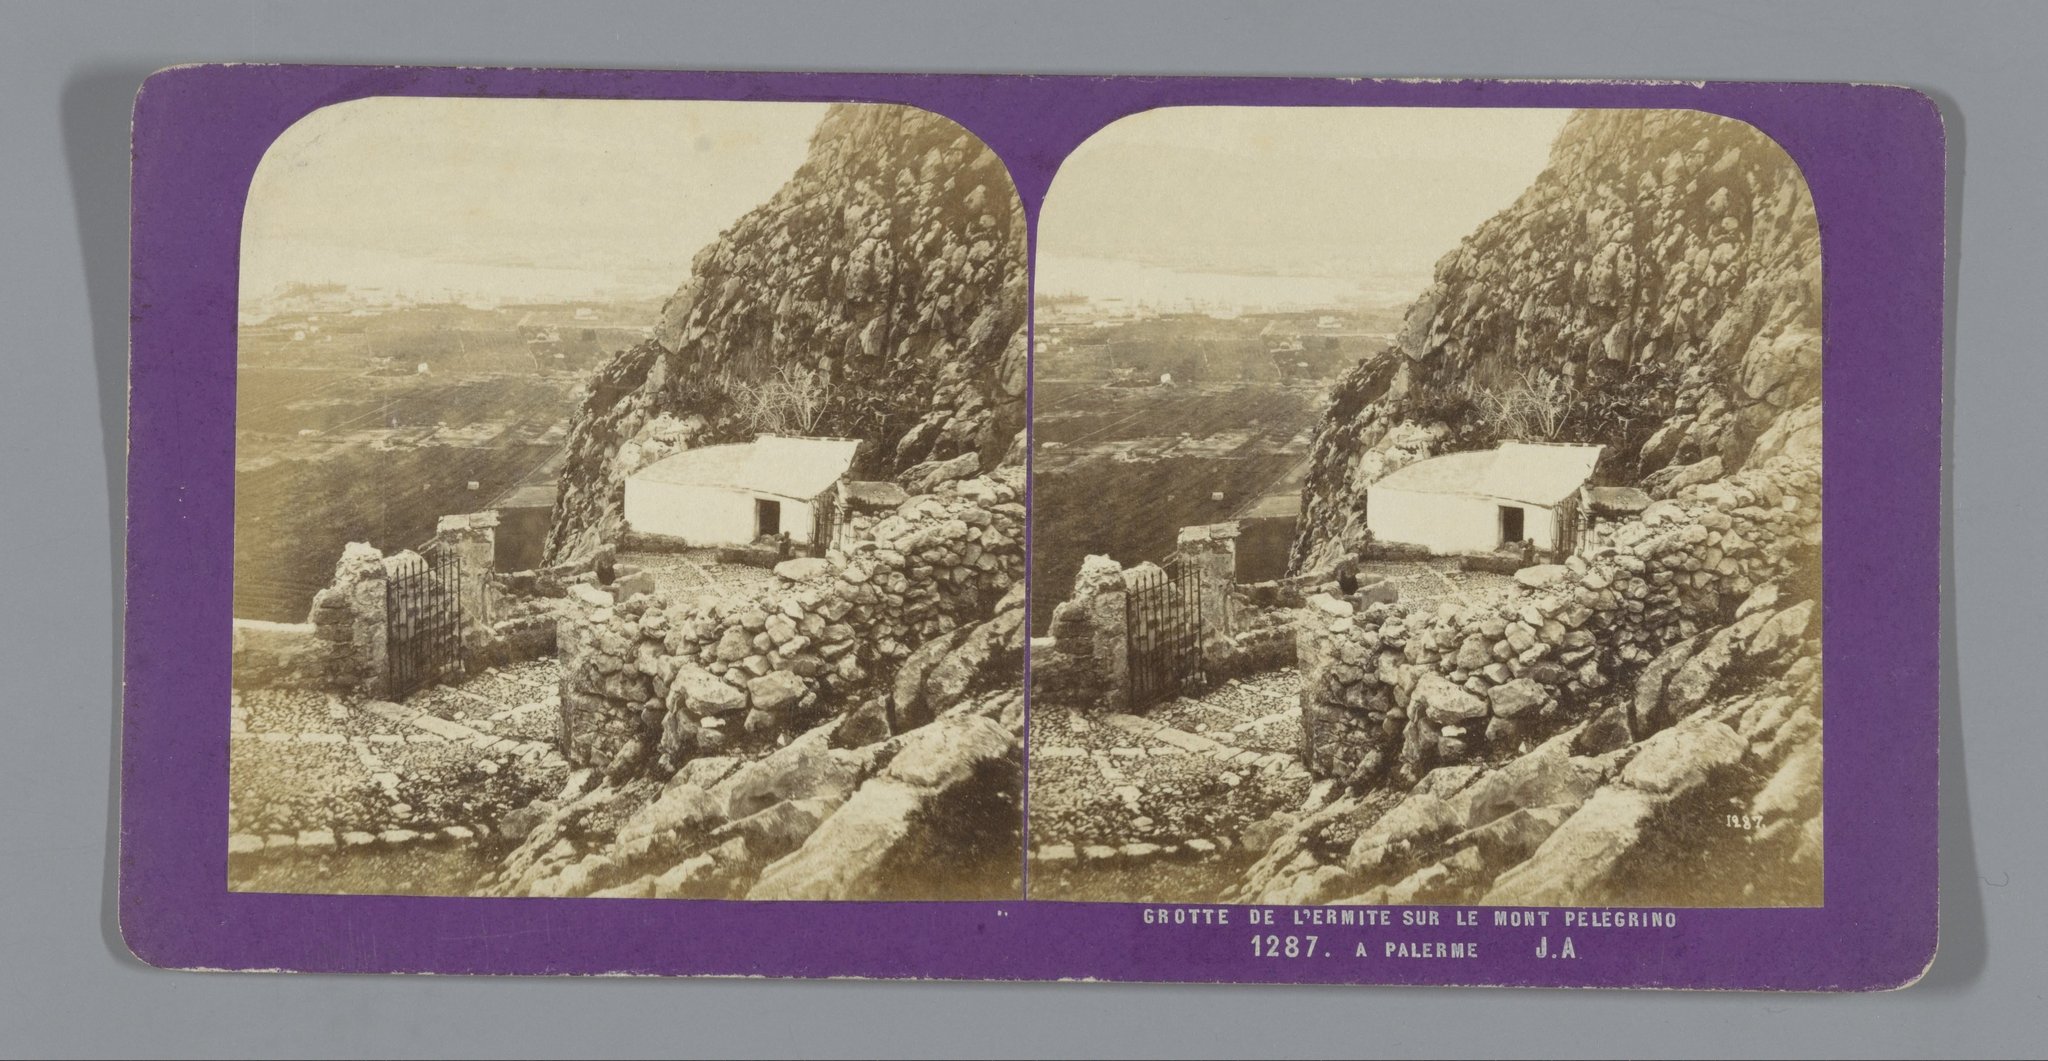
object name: stereograph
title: Grotte de l'Ermite sur le Mont Pélégrino, a Palerme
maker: jean andrieu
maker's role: fotograaf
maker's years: 1816-1872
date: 1862-1876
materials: cardboard, paper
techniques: albumen print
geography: palermo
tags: housing, mountains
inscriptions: number: ‘1287’